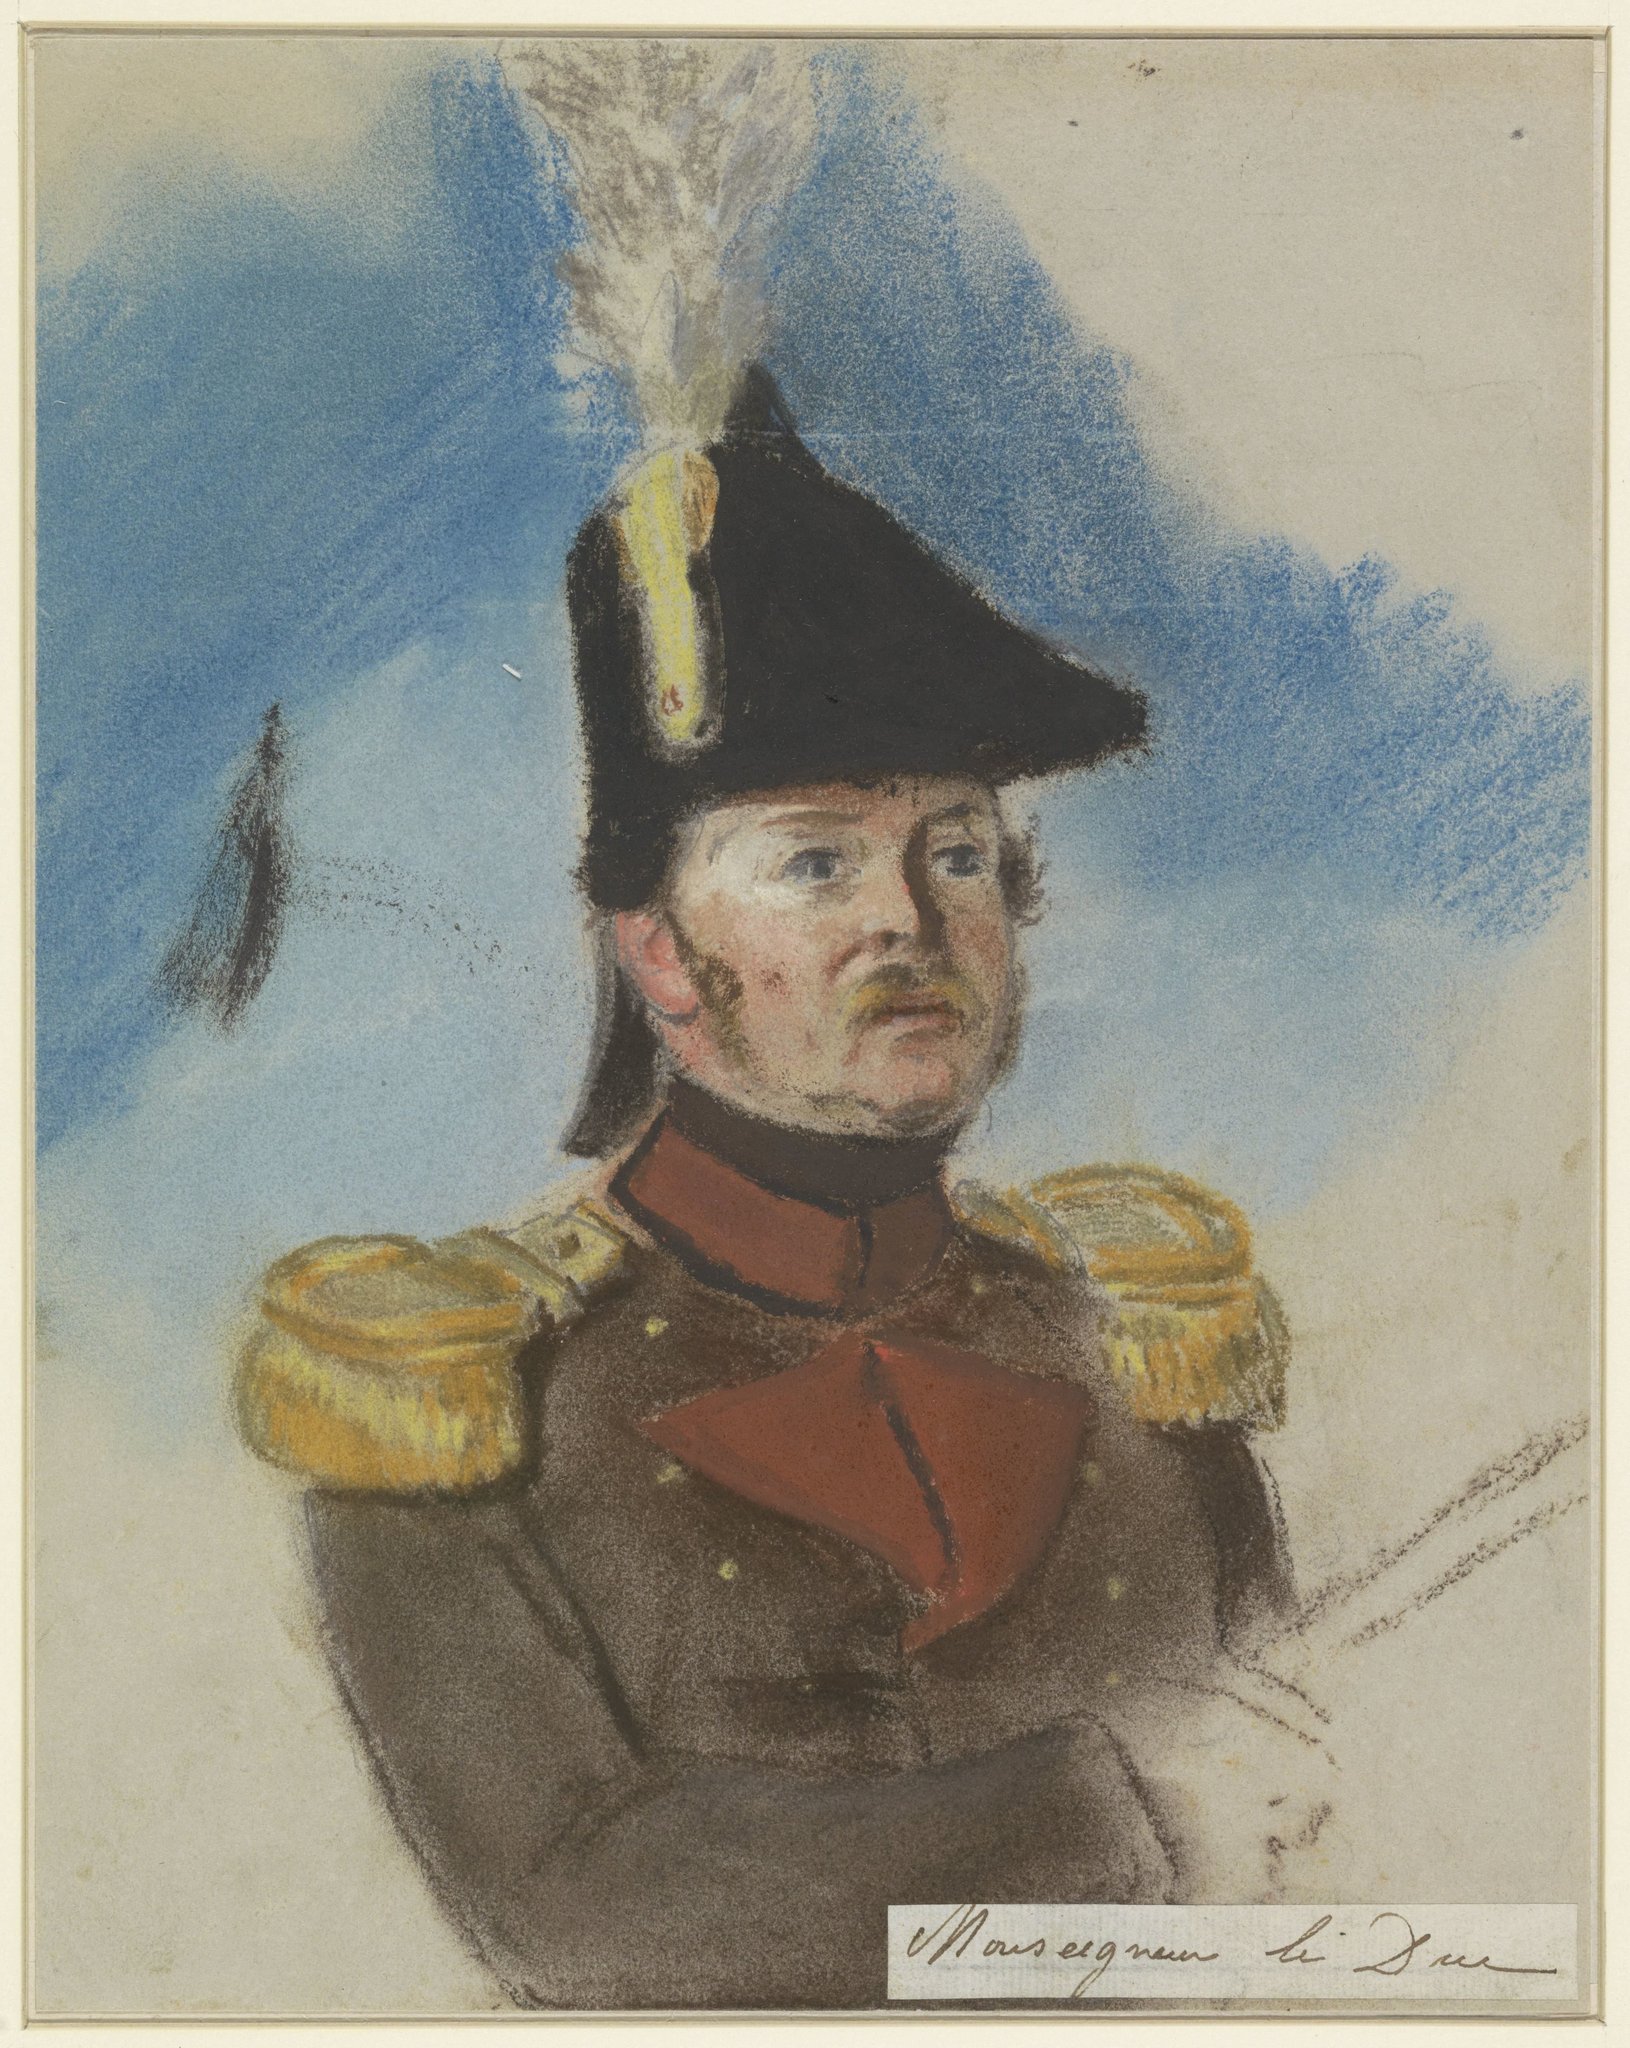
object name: drawing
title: Portret van Bernard, hertog van Saksen-Weimar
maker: jacob joseph eeckhout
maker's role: draughtsman, print maker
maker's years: 1793-1861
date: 1803-1861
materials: paint, paper, pastel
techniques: brush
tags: historical persons